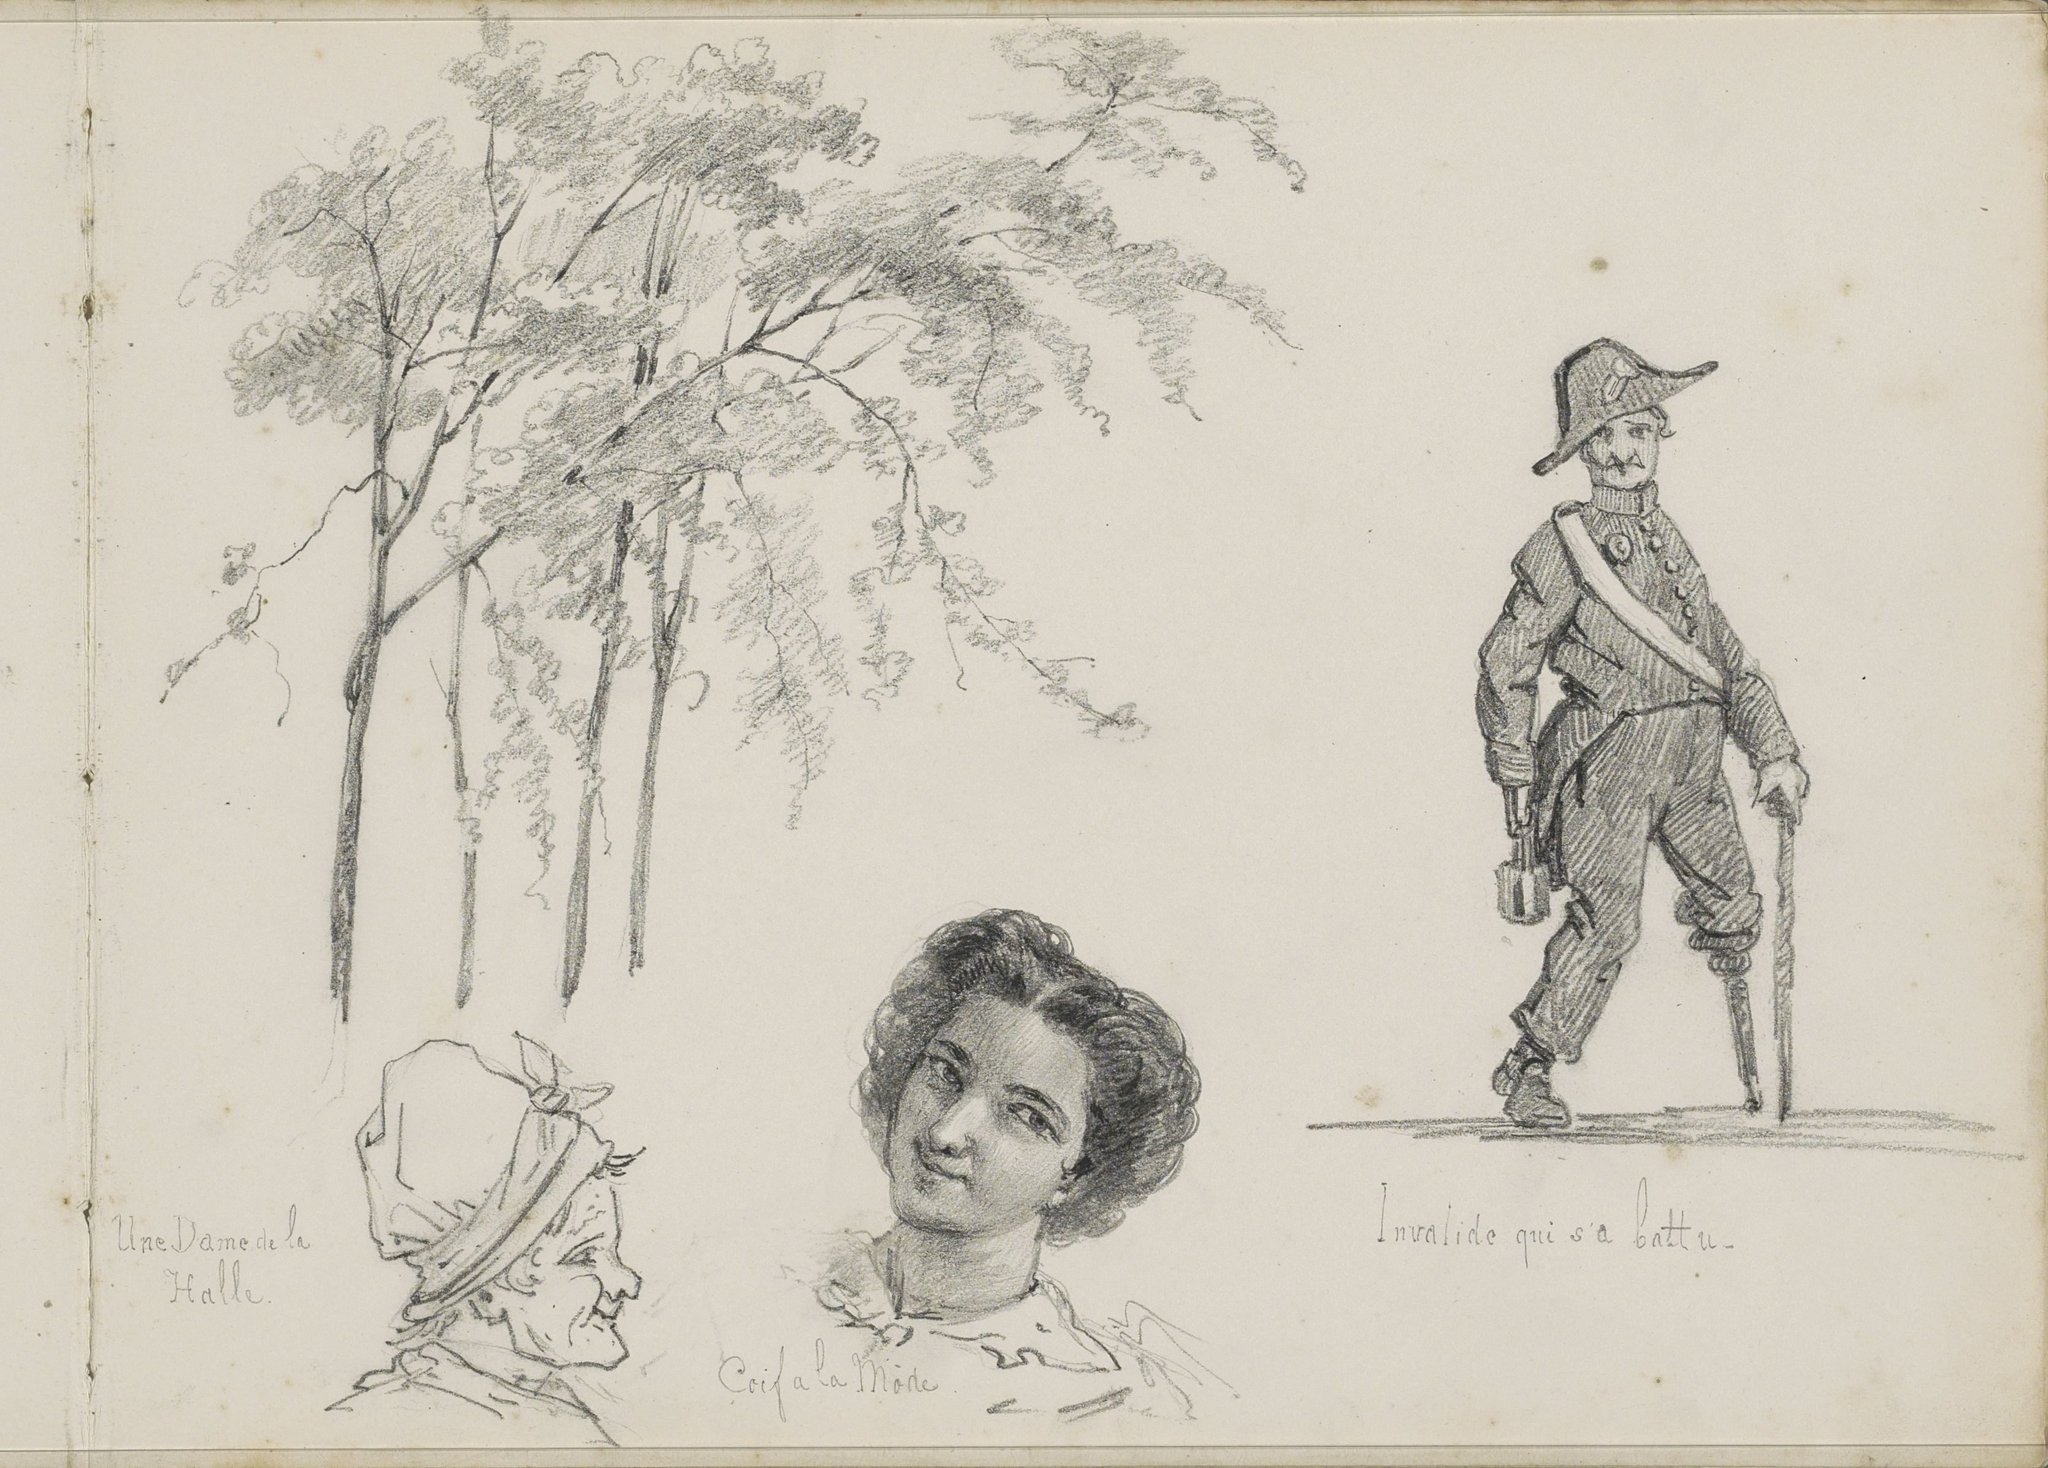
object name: sketchbook leaf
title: Kop van een verkoopster, een modieus kapsel en een gehandicapte soldaat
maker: gerrit postma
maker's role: draughtsman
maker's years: 1819-1894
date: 1858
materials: paper, pencil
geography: france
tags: trees, persons engaged in trade and commerce - bb - women engaged in trade and commerce, wooden leg, styles of hairdress - aa - ~ women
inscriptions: annotation: ‘Une Dame de la Halle/ Coif a la Mode/ Invalide qui sa battu’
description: Tevens studies van bomen. Blad 4 recto uit een schetsboek met 52 bladen.